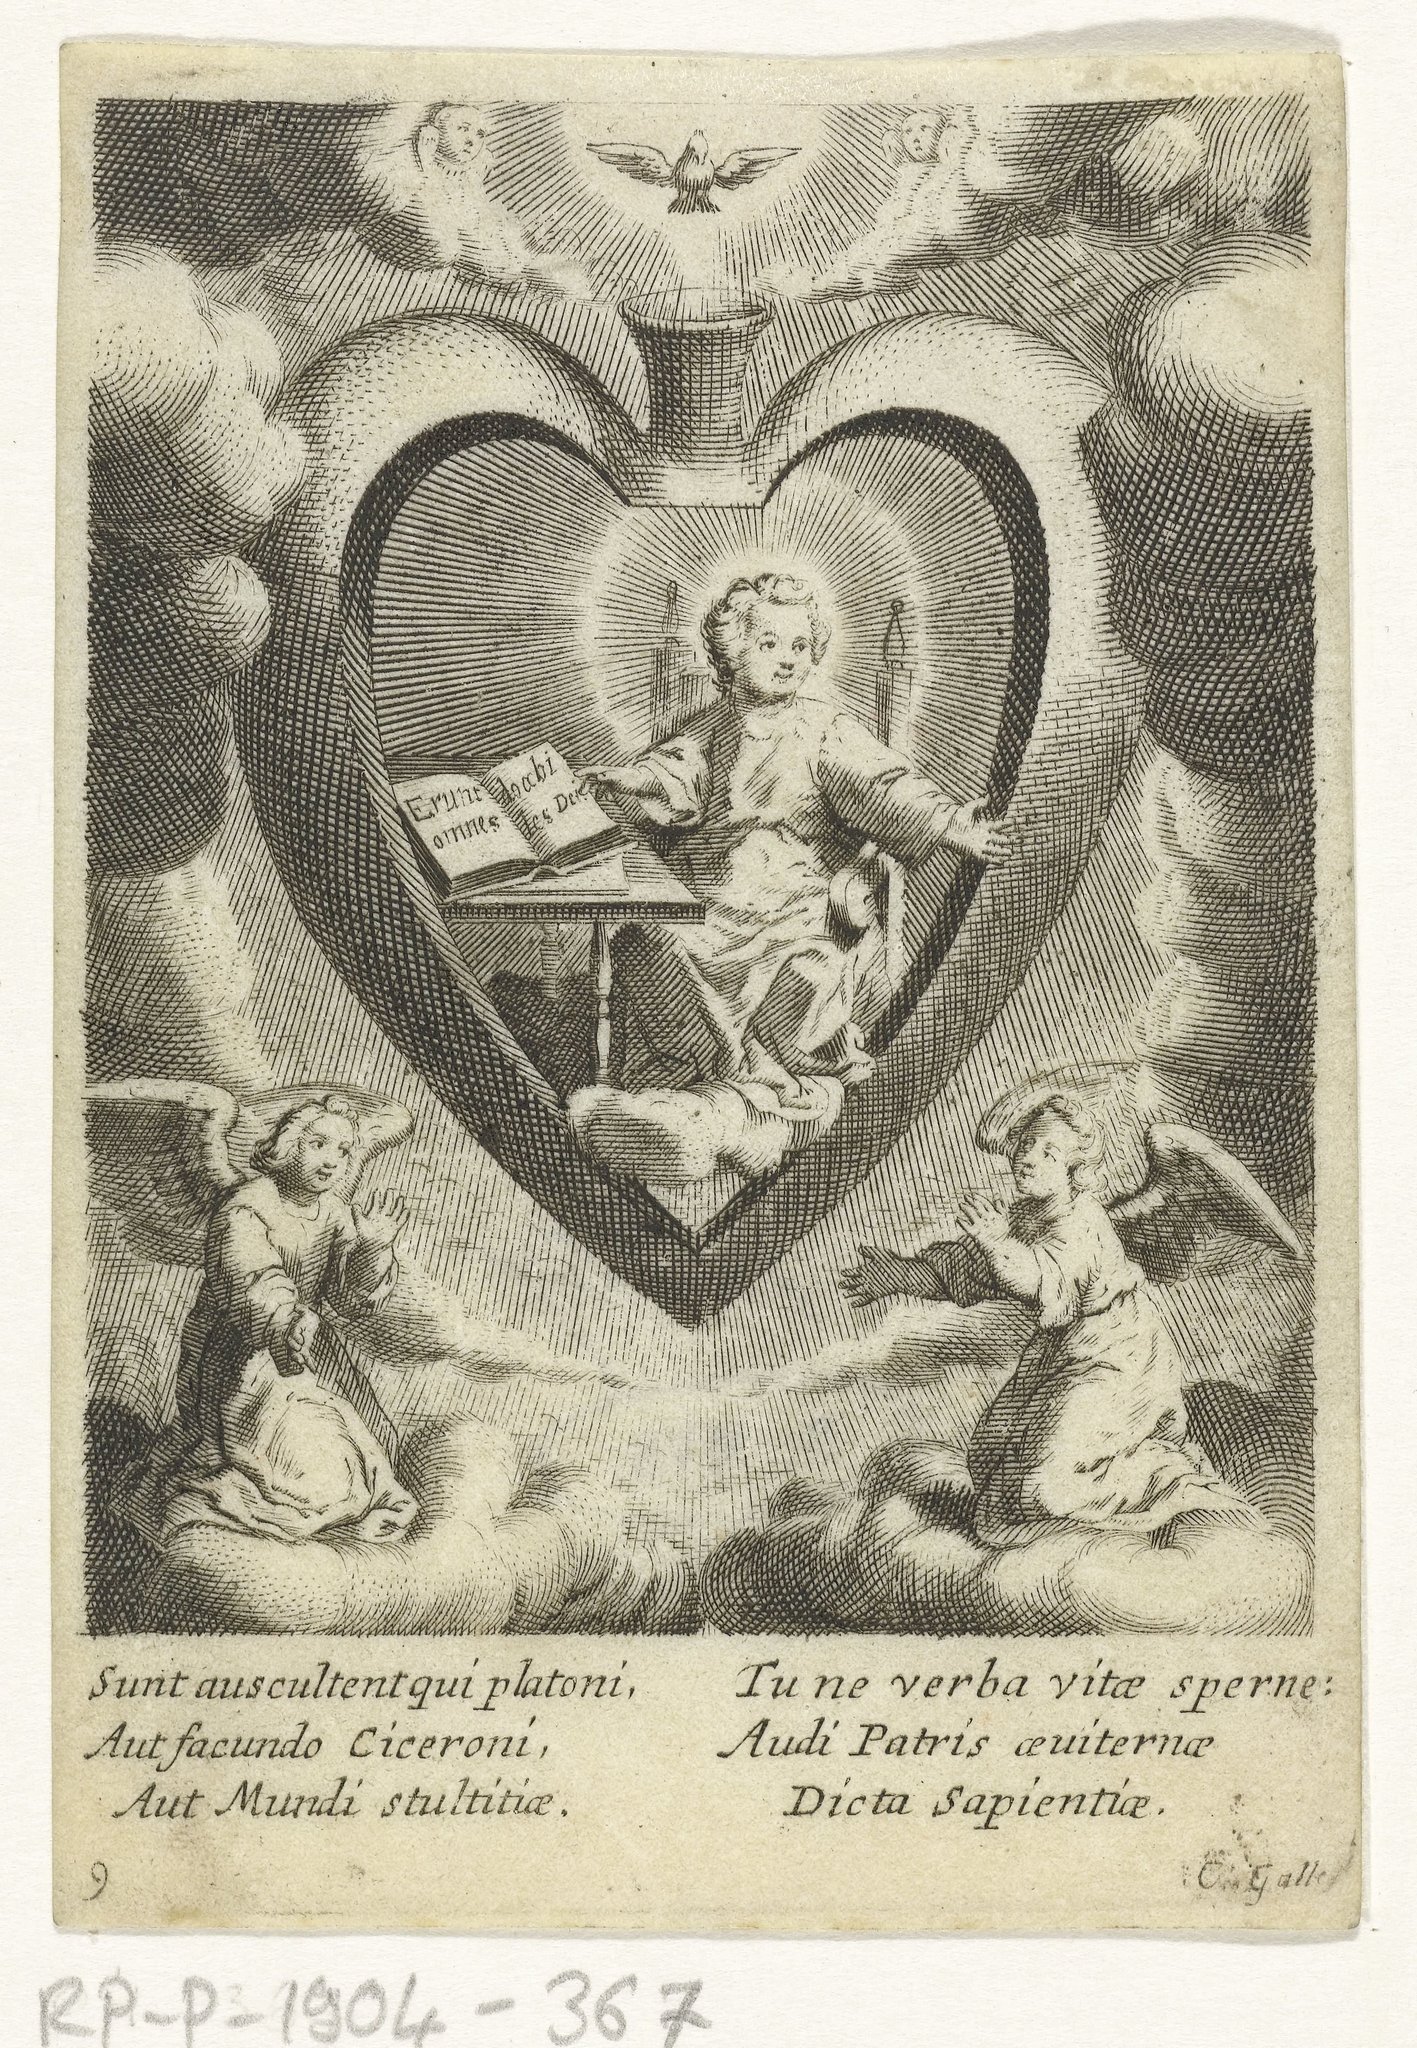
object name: print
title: Christuskind met boek in hart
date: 1638-1678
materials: parchment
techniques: engraving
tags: heart symbolism, christ-child (with attributes)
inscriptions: collector's mark: Lugt 2228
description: Het Christuskind zit aan een tafel en wijst op een open boek. In een omlijsting in de vorm van een hart. Het Kind wordt aanbeden door twee knielende engelen. Onder de voorstelling een Latijns vers.